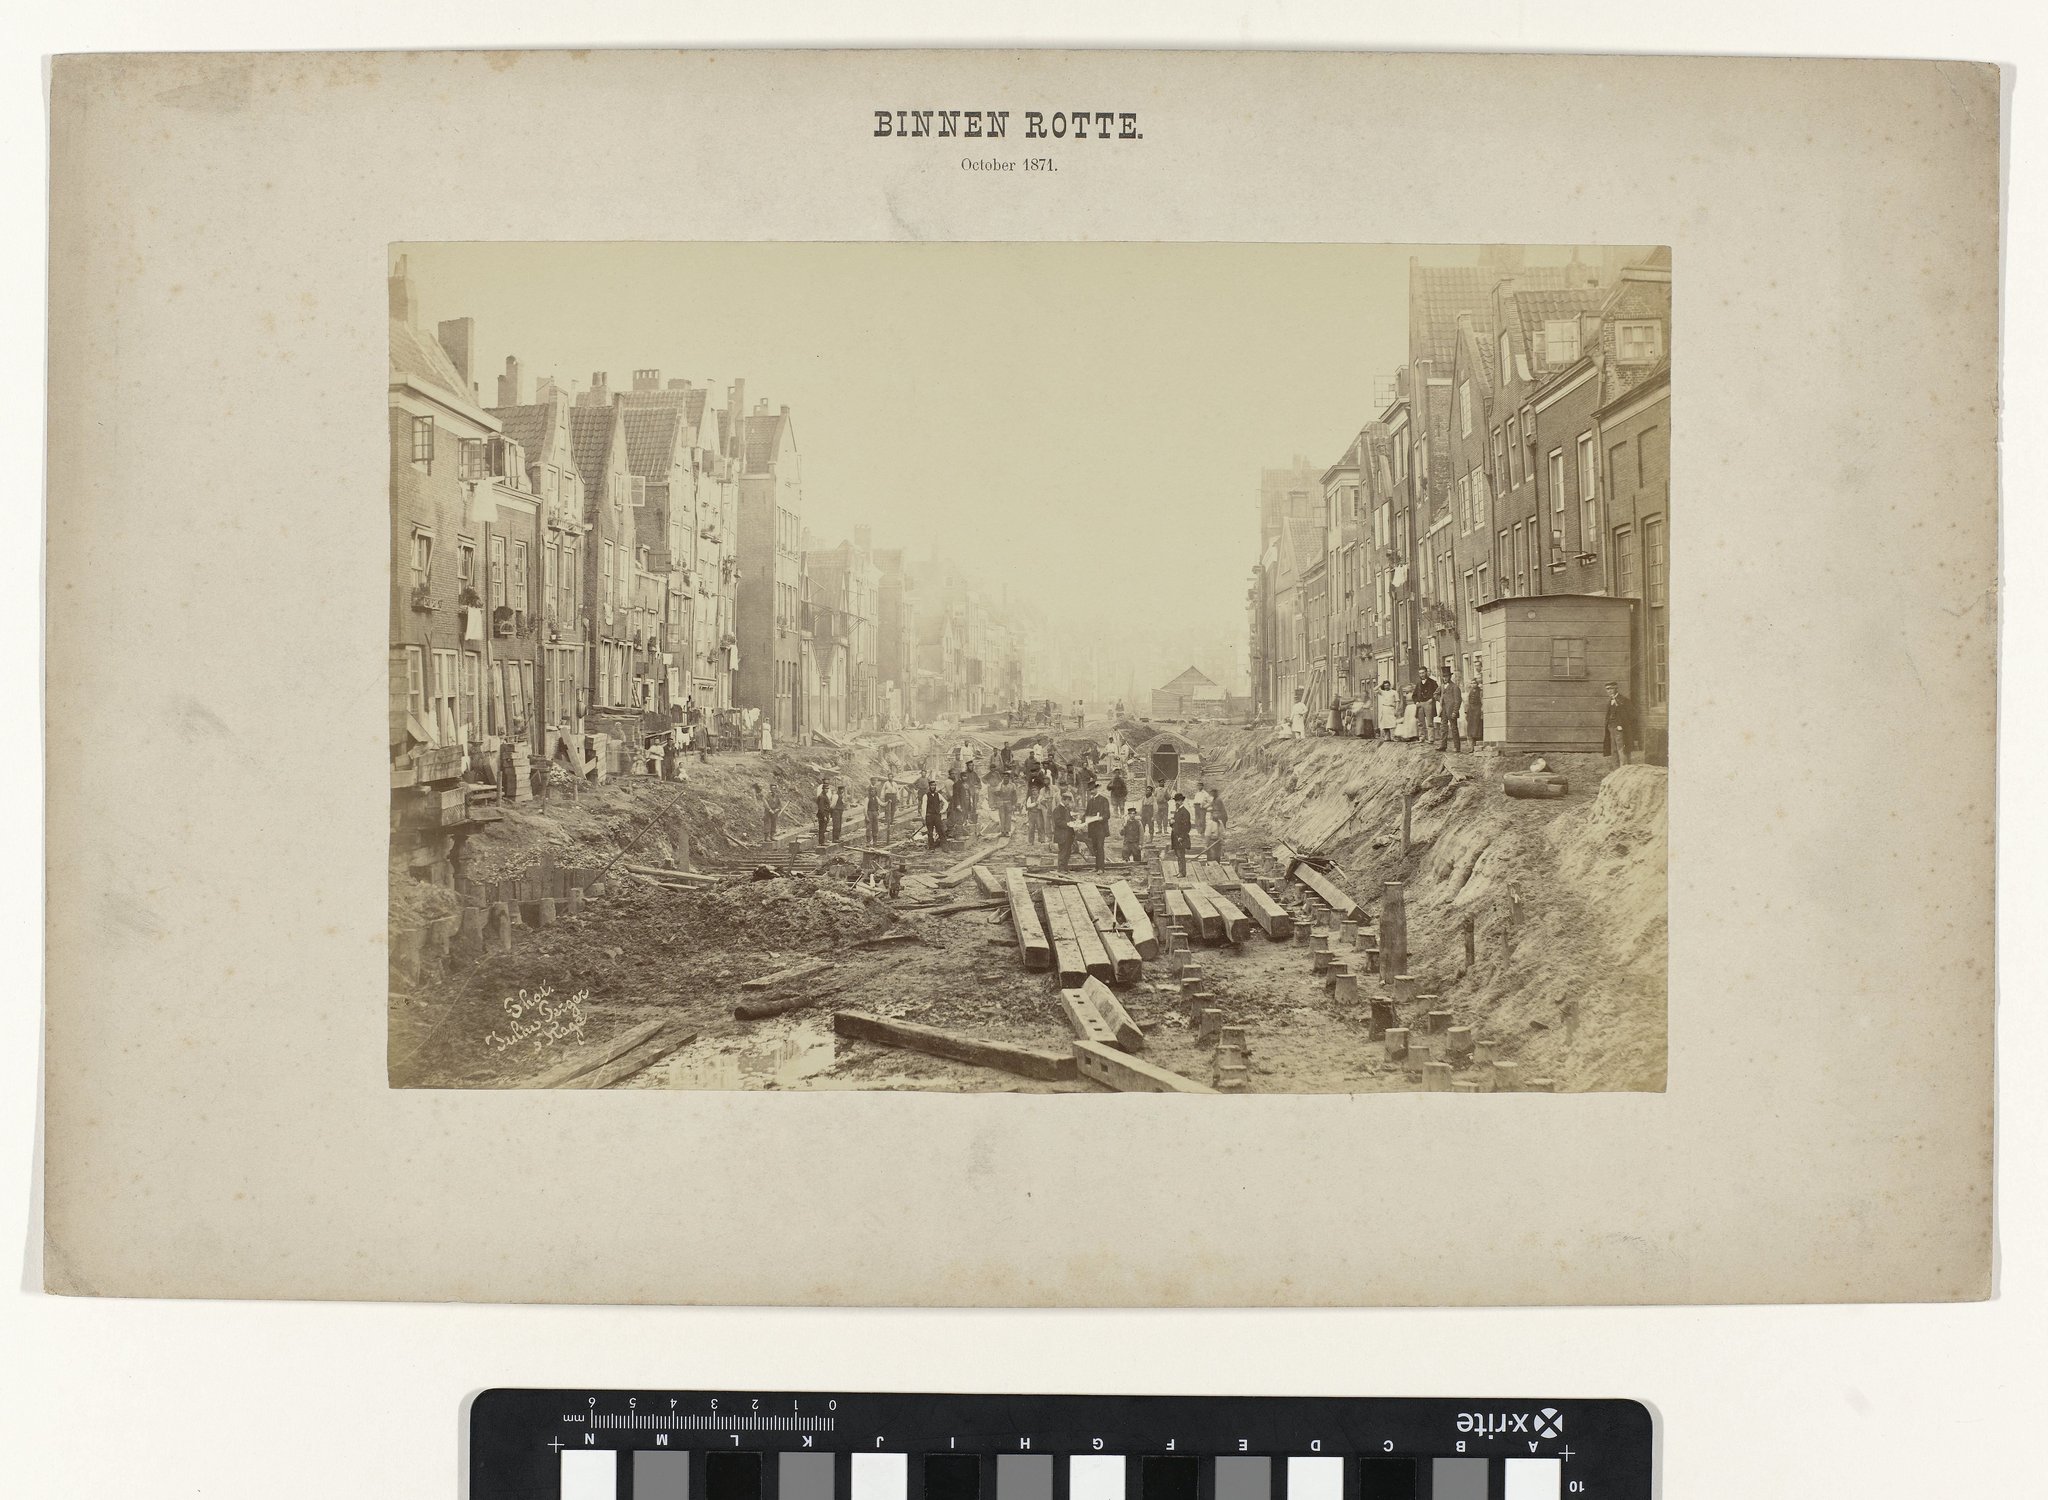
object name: photograph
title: Binnen Rotte October 1871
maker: julius perger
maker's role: fotograaf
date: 1810-1871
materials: cardboard, photographic support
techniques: albumen print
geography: rotterdam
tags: digging (industrial process), canals, waters (in city), public road, city-view in general; 'veduta' - ii - ideal city, rotterdam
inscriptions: signature: ‘Phot. Julius Perger 's Hage’